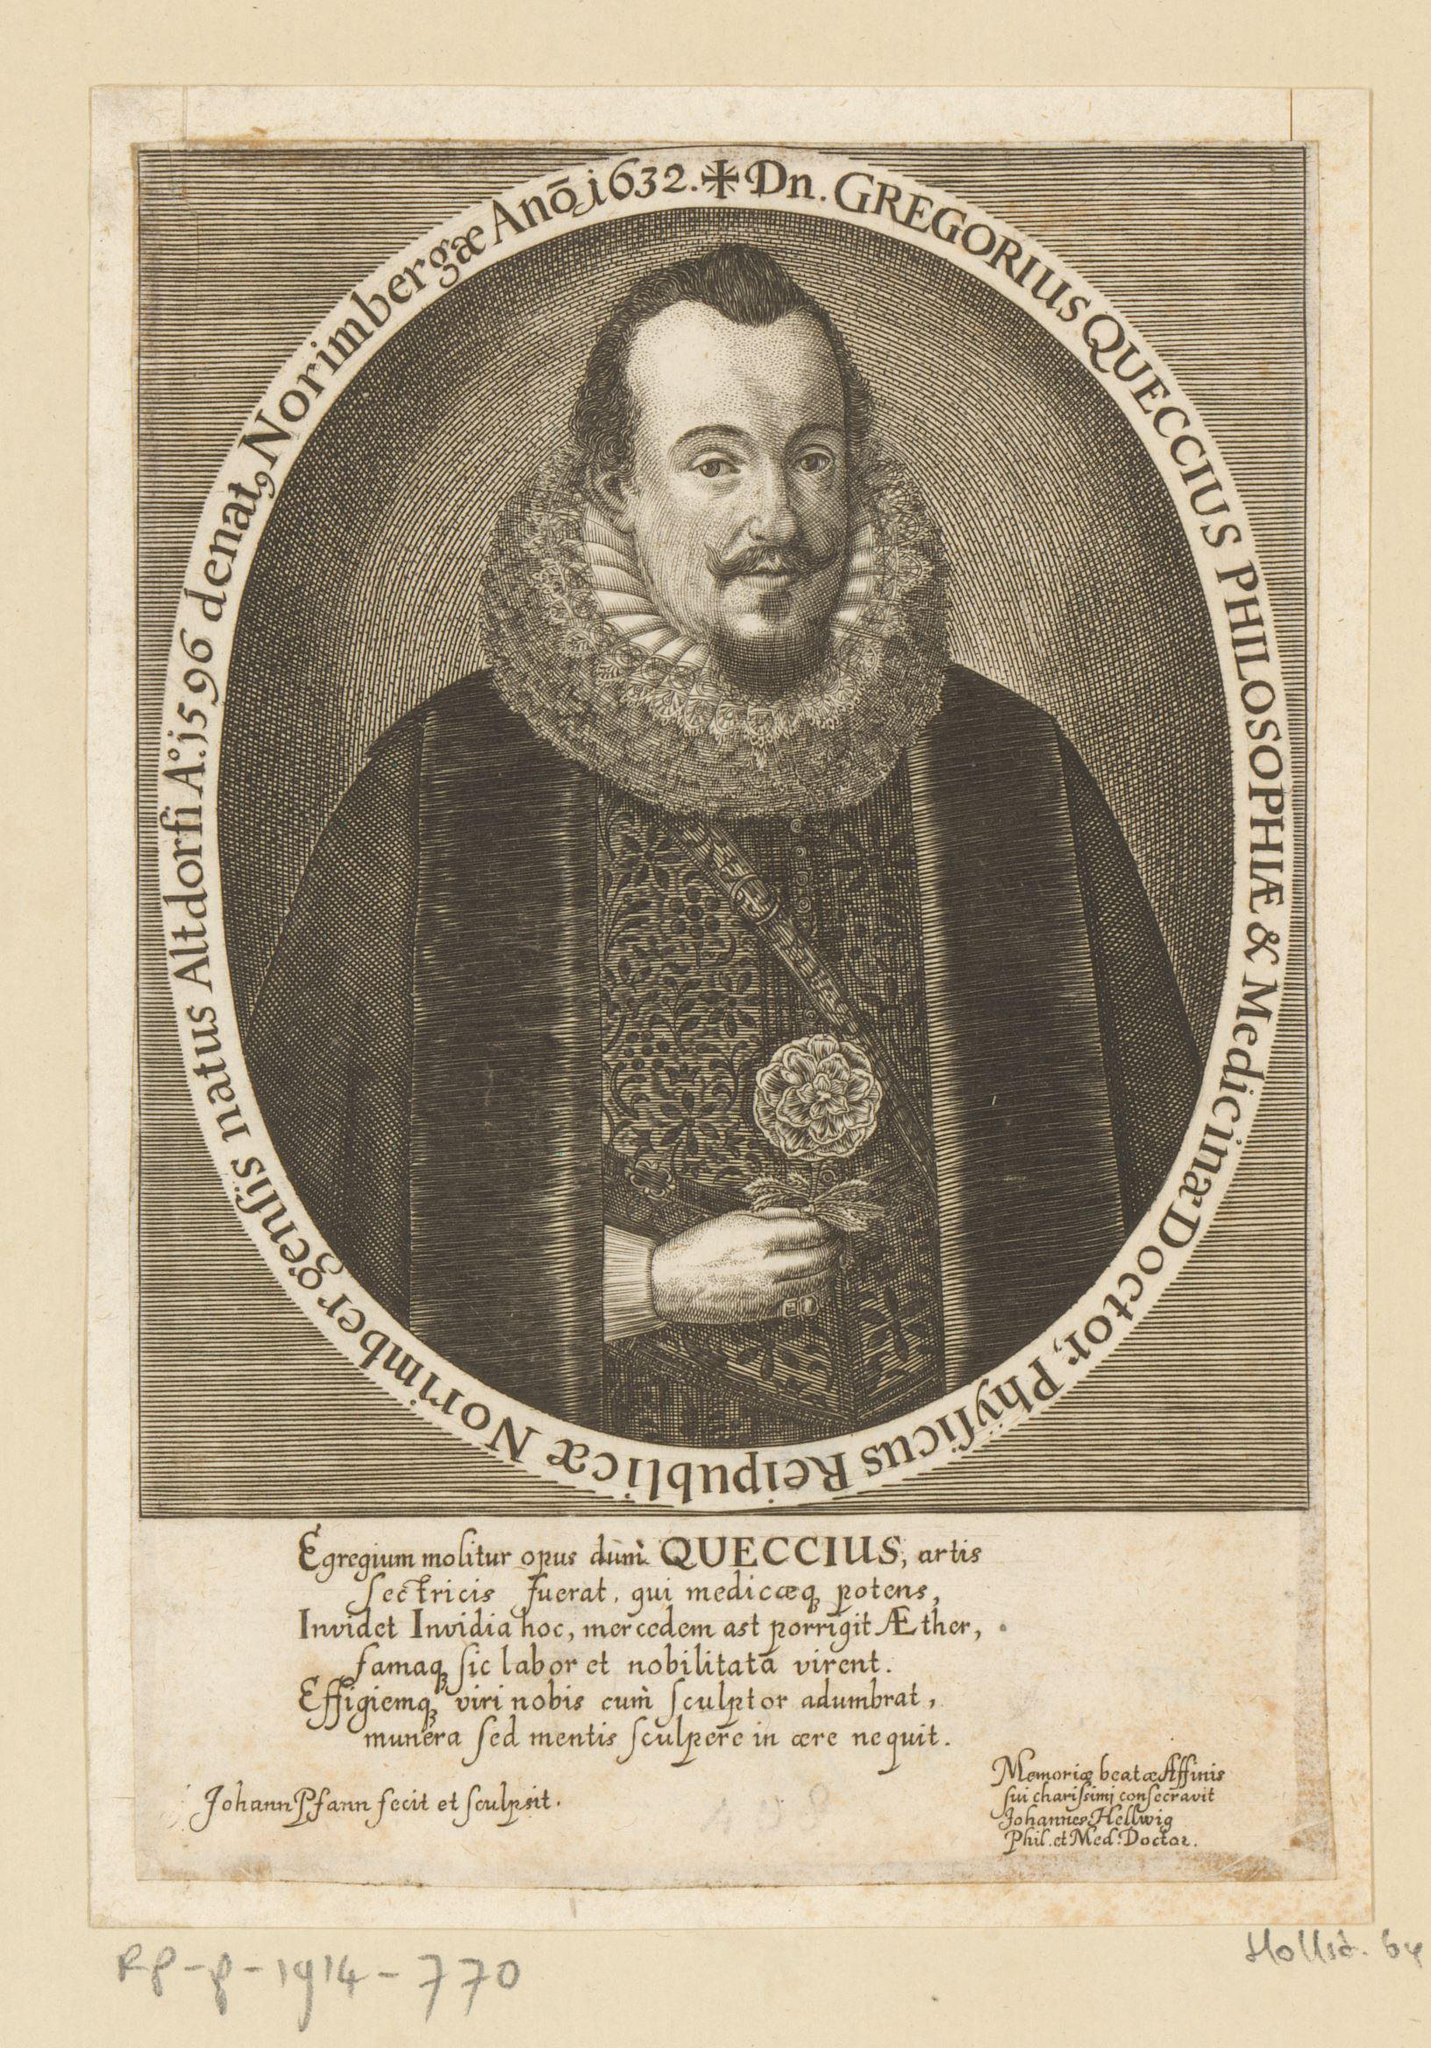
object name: print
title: Portret van Gregor Queck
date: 1648-1663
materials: paper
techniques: engraving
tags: flowers, historical persons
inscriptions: collector's mark: Lugt 2228